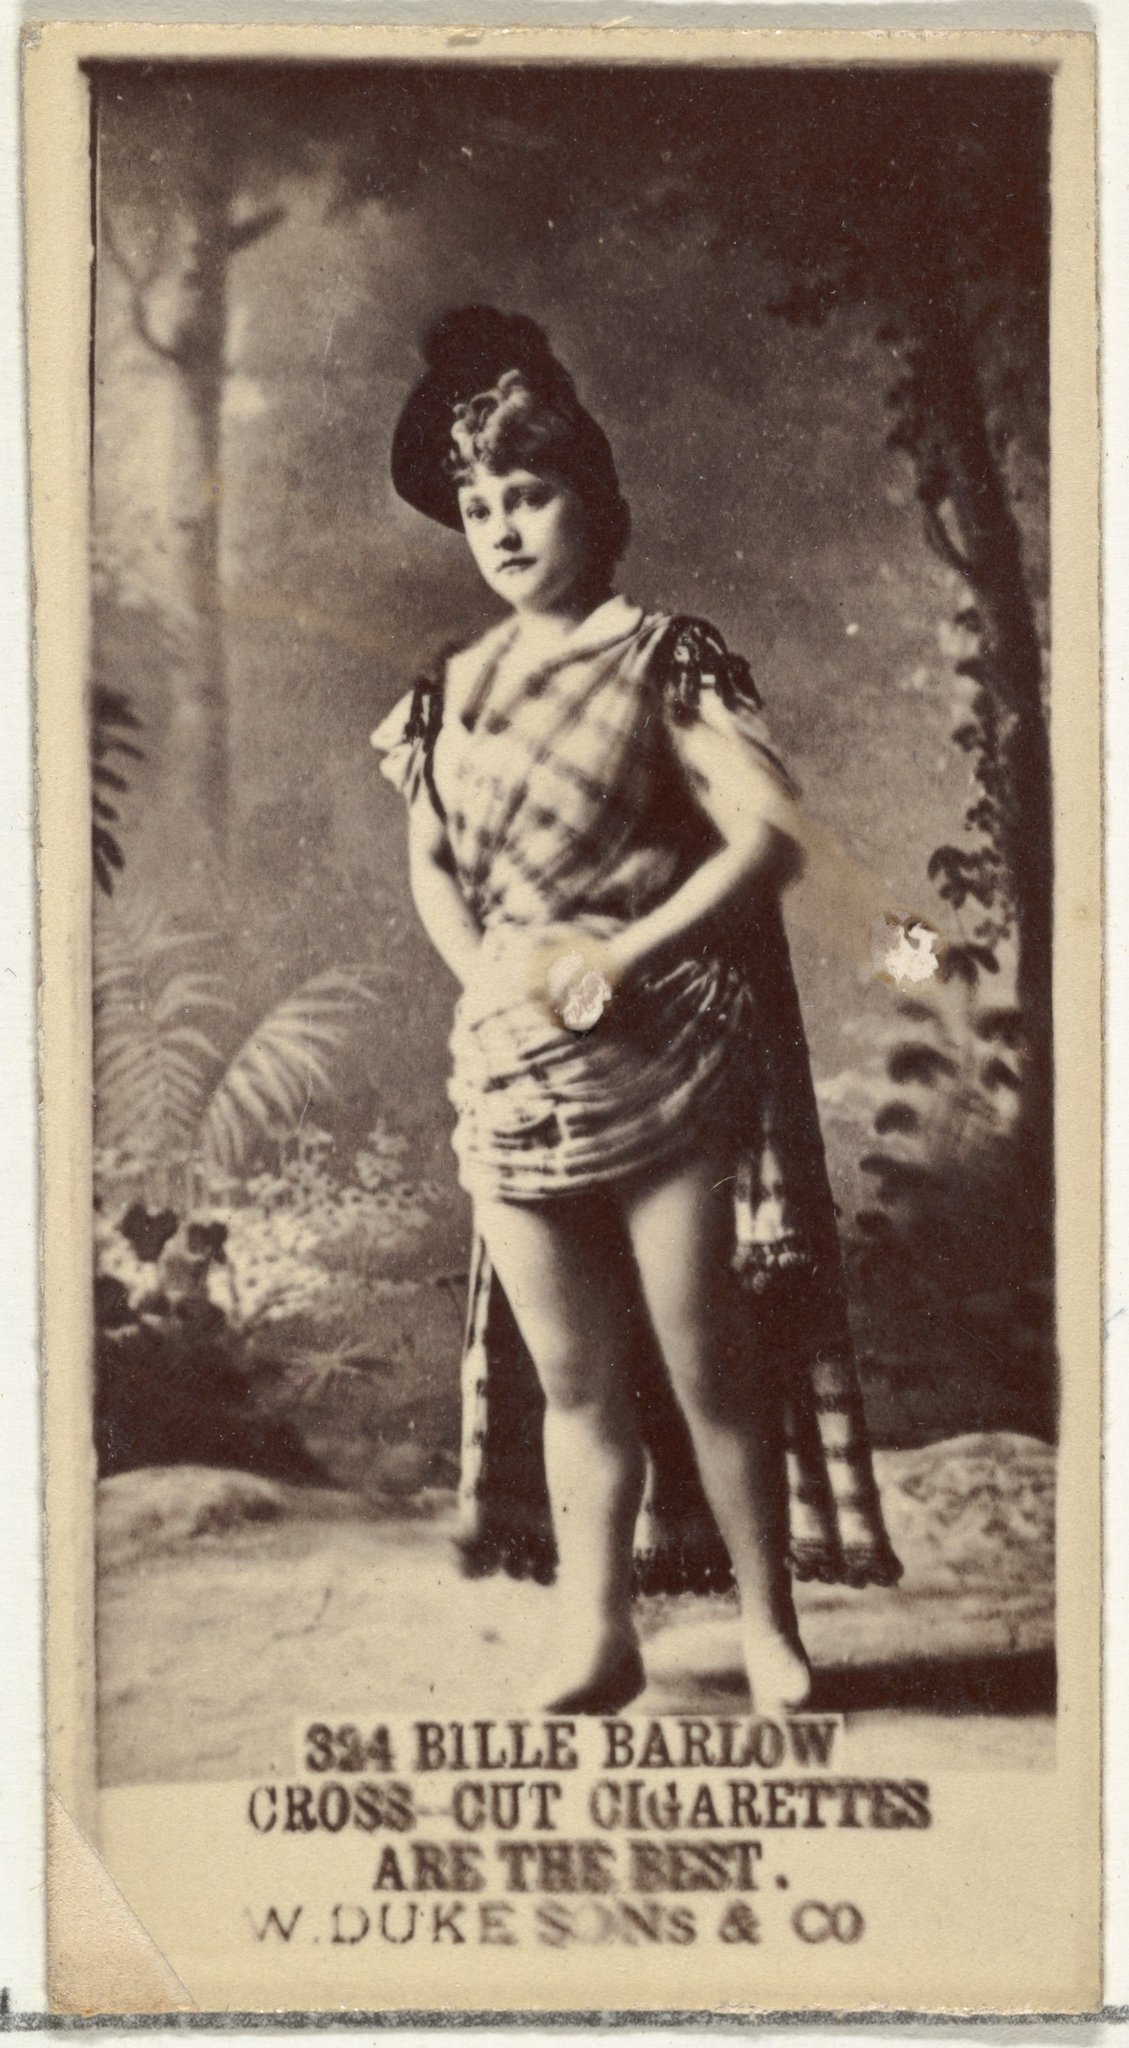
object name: photograph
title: Card Number 324, Billie Barlow, from the Actors and Actresses series (N145-3) issued by Duke Sons & Co. to promote Cross Cut Cigarettes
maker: w. duke, sons & co.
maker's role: publisher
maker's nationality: american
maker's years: 1870-1920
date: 1880-1889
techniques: albumen silver print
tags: portraits,women,actresses